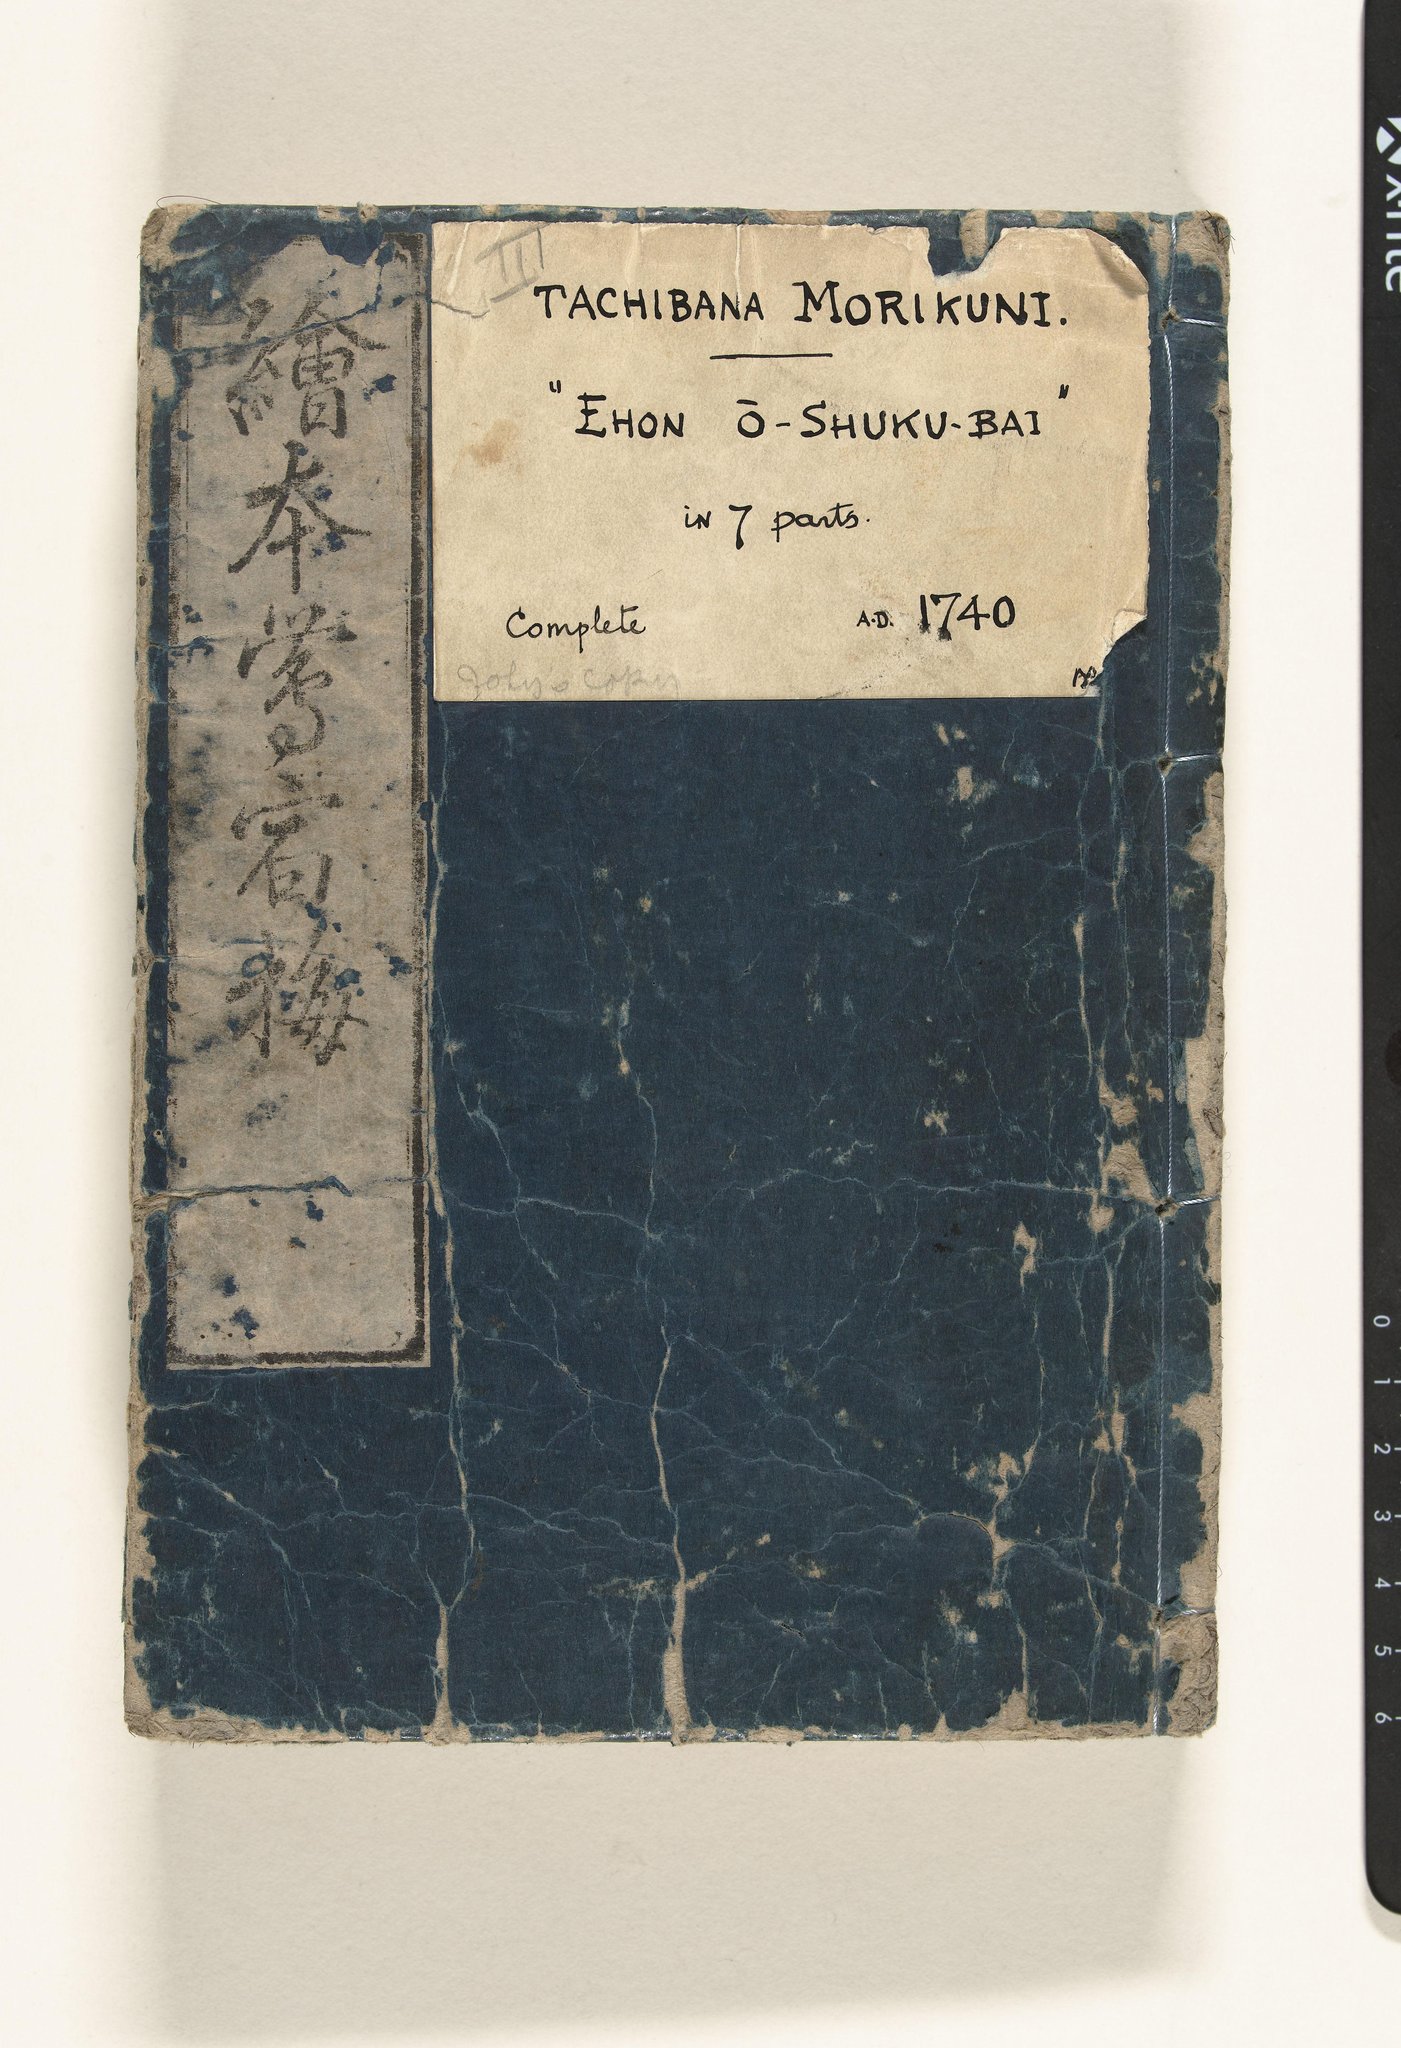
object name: book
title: Geïllustreerd boek over bloemen, dichters en vogels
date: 1740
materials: paper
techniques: woodcut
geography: osaka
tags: landscapes, temple, shrine ~ non-christian religions, bridge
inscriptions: collector's mark: ‘H.L.Joly’, collector's mark: Lugt 2228, collector's mark: Lugt 2760